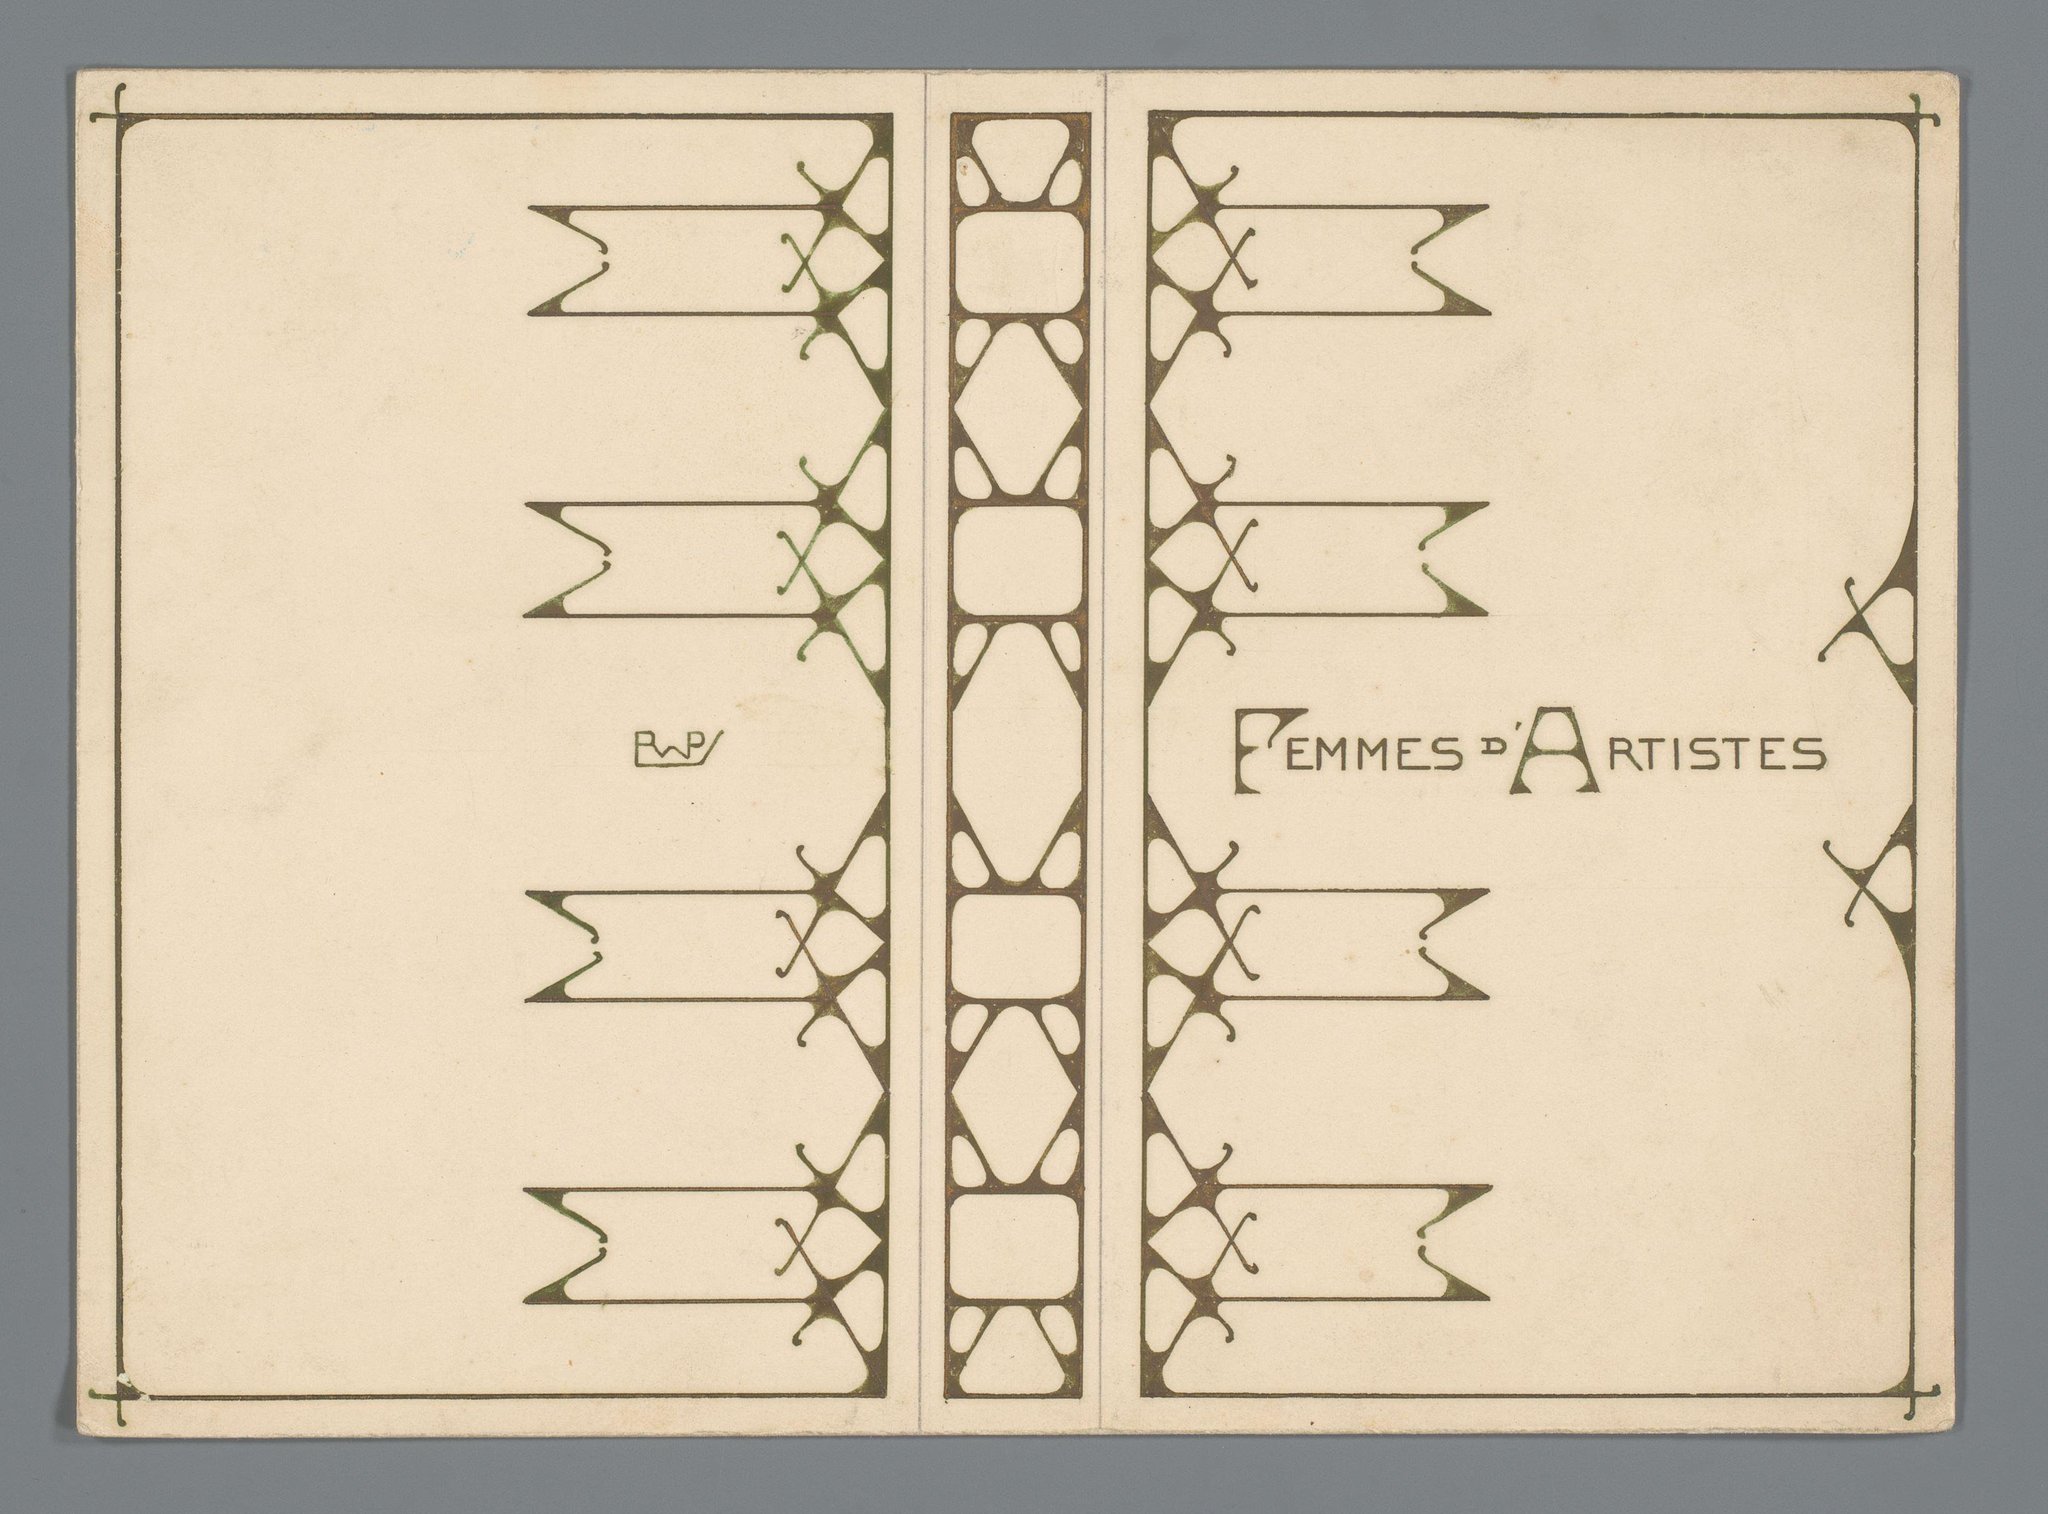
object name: study for binding design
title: Bandontwerp voor: Alphonse Daudet, Femmes d'artistes, zonder jaar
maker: reinier willem petrus de vries (1874-1953)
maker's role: draughtsman, print maker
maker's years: 1874-1953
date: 1884-1952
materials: paint, paper, pencil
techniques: brush, pen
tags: ornaments ~ art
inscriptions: number: ‘7.’, collector's mark: ‘R:MVS.’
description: Bandontwerp voor: Daudet, Alphonse. Femmes d'artistes. S.l.s.n., [z.j.].